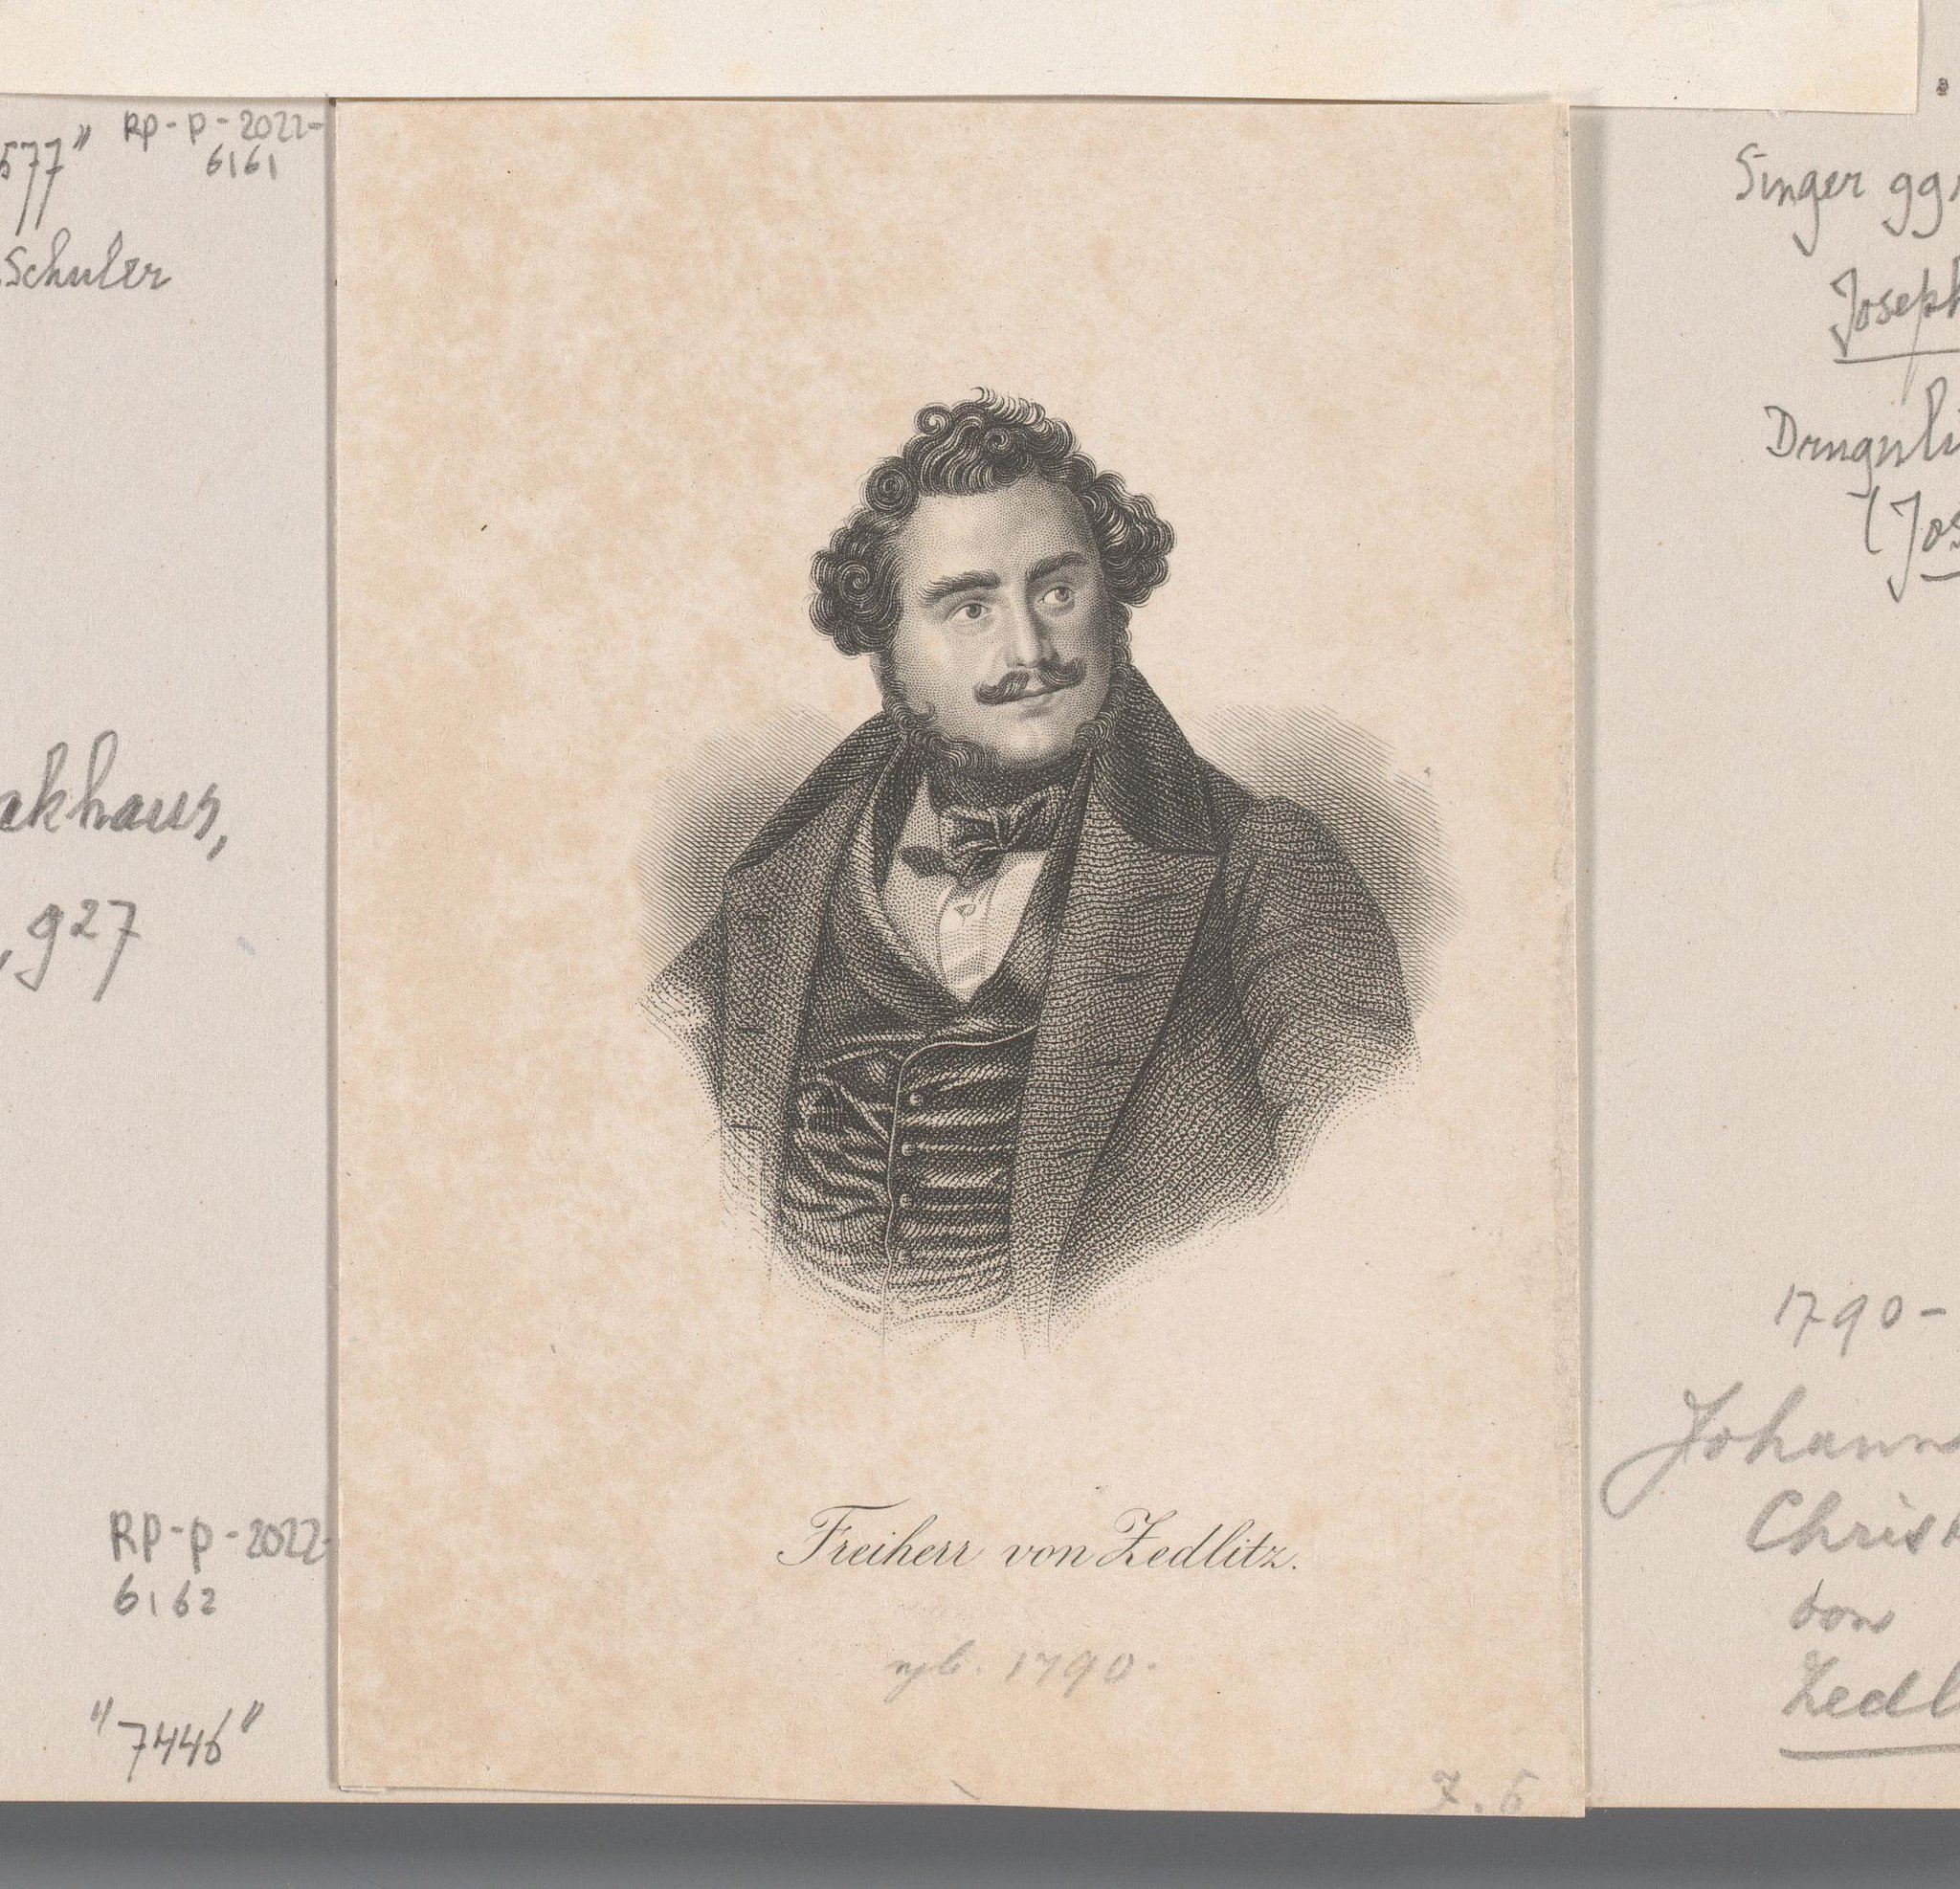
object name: print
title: Portret van Joseph Christian von Zedlitz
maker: Anonymous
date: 1810-1862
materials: paper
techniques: engraving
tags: historical persons, portrait of a writer, officer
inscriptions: number: ‘7446’